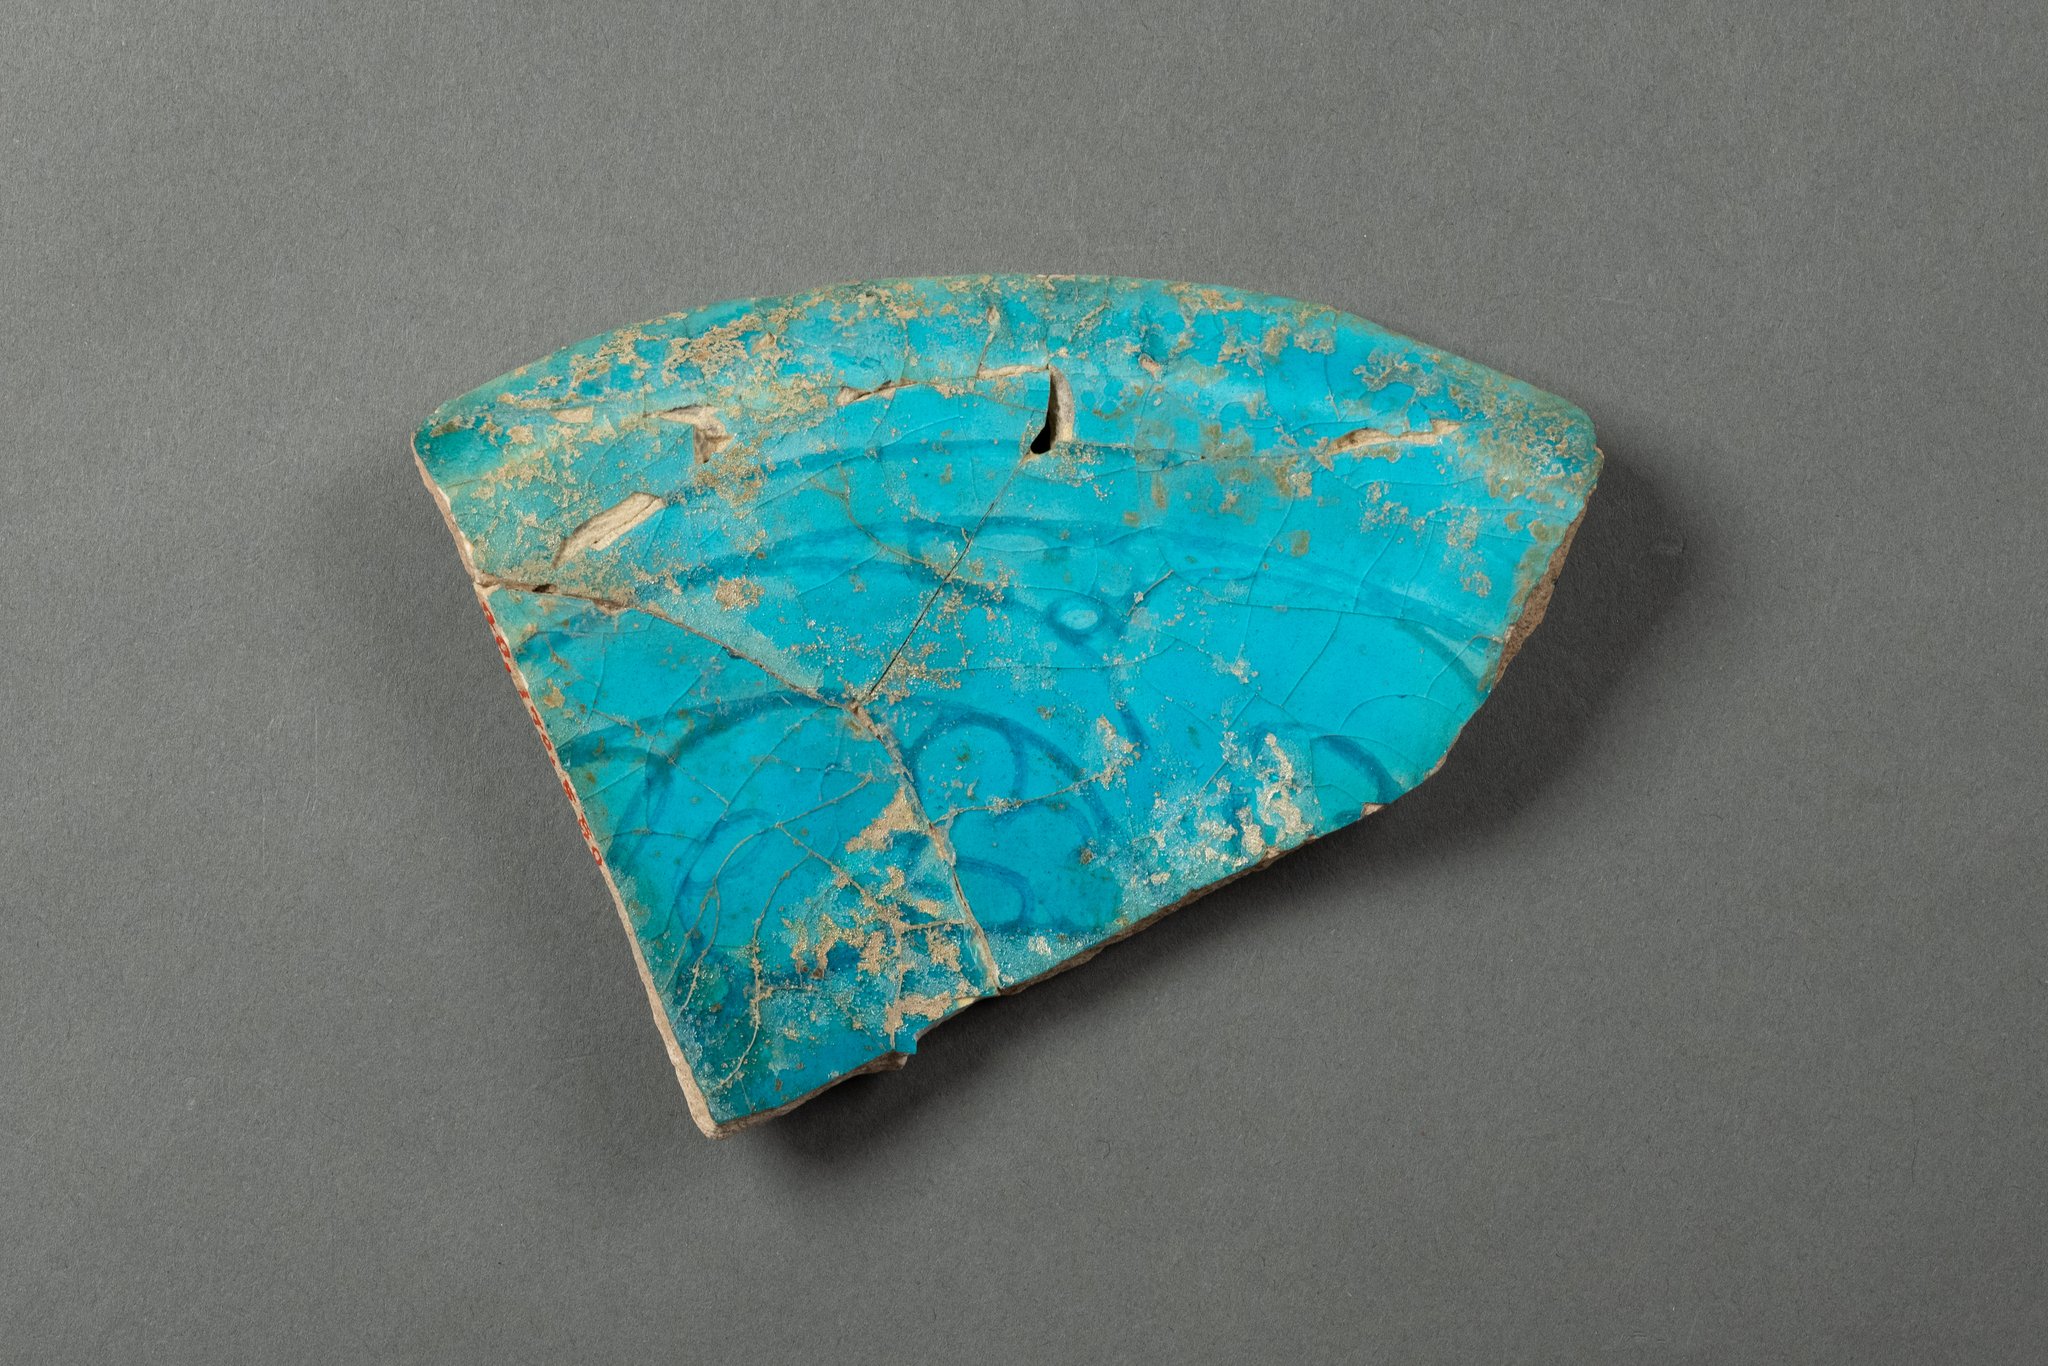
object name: fragment of a dish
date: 1001-1200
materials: earthenware, glaze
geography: iran